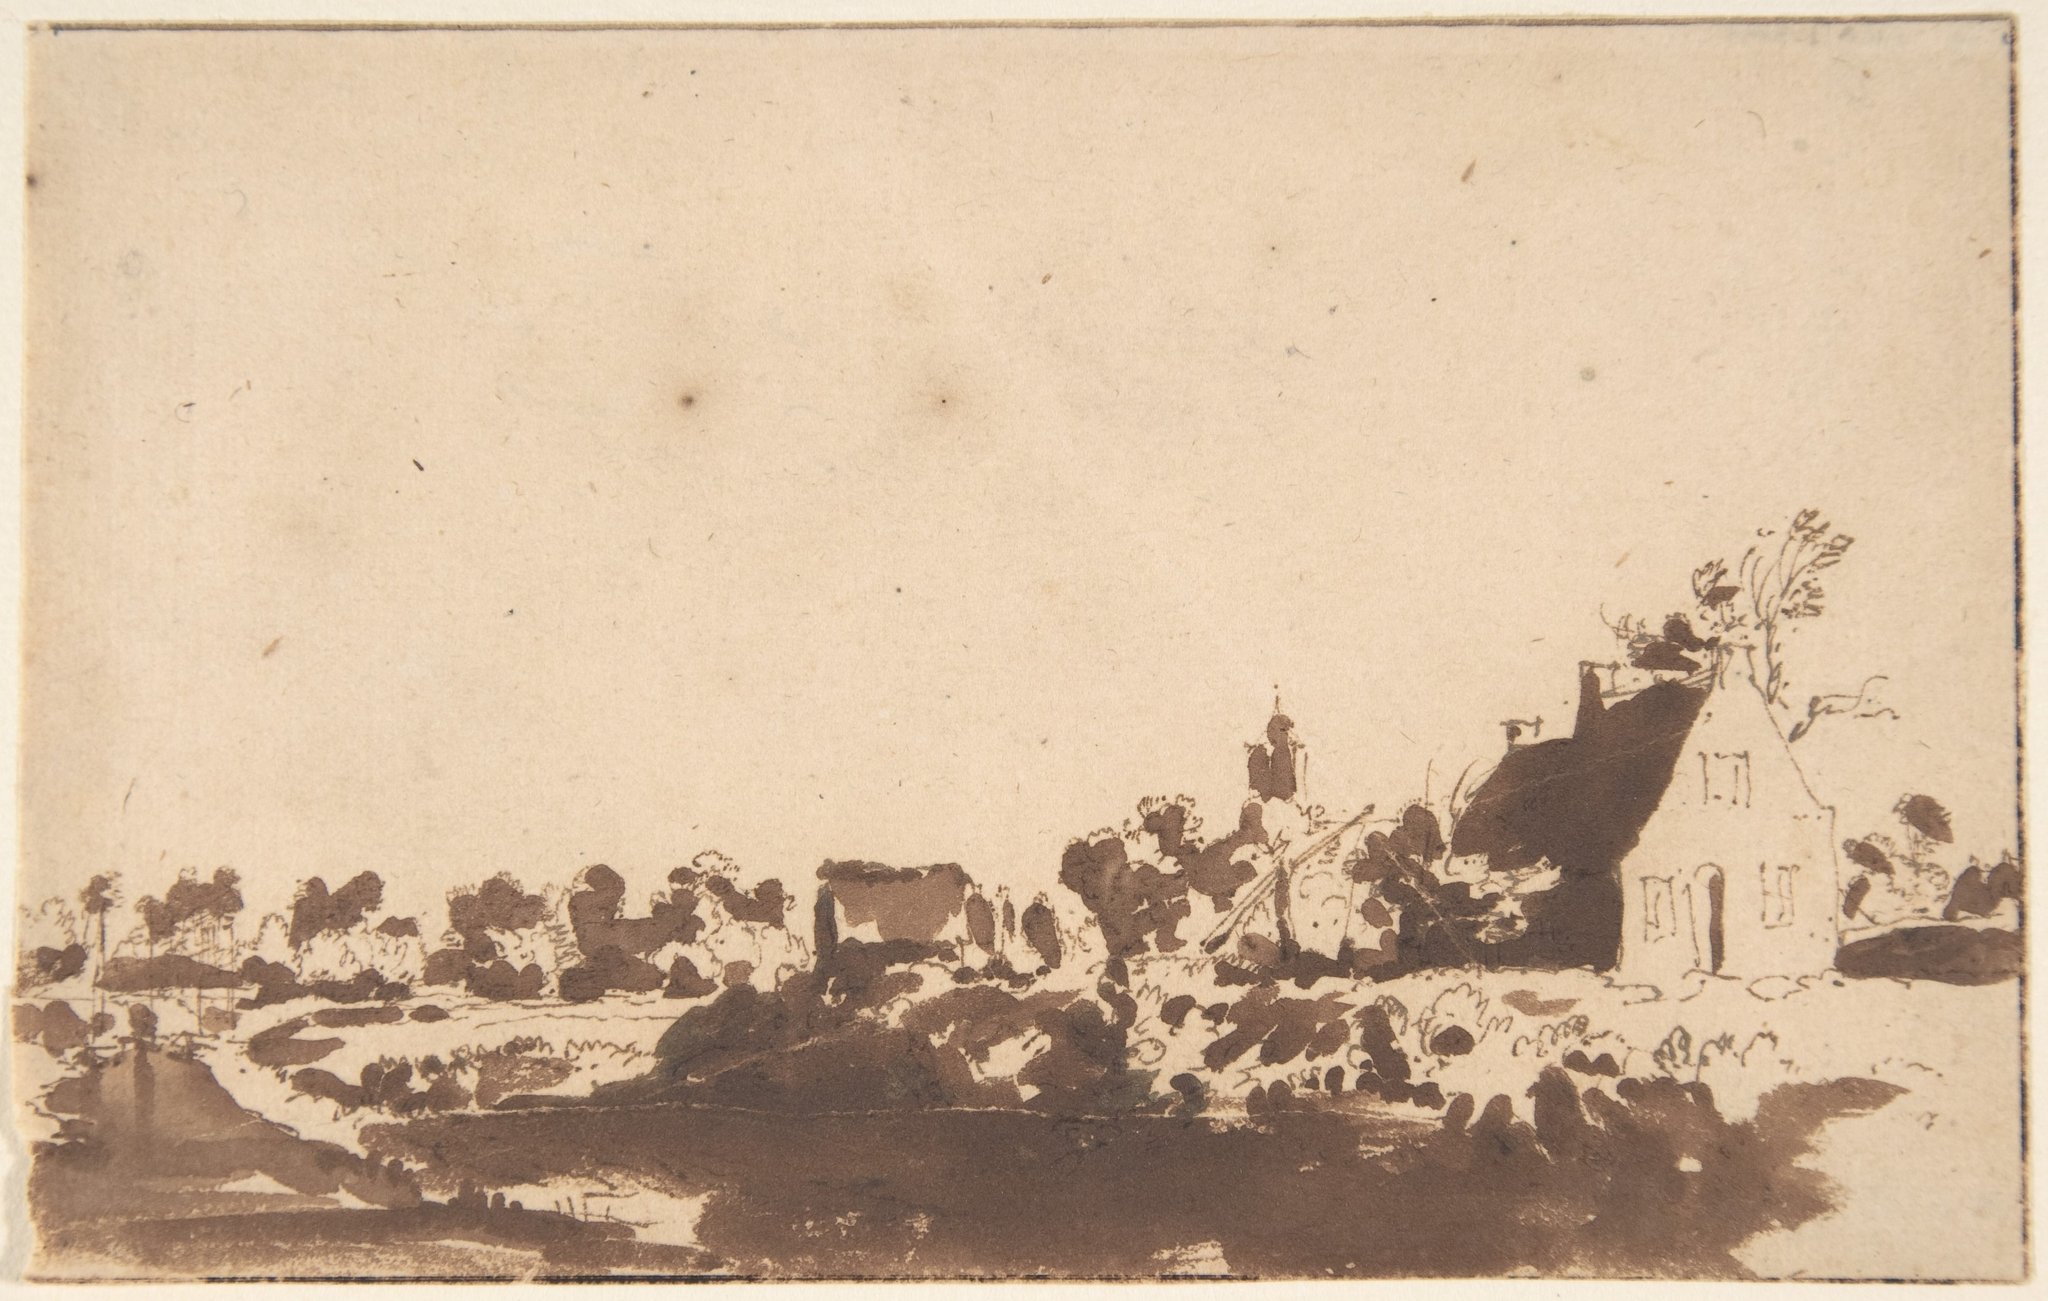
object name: drawing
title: View of a Village ("Wasschout"?)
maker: jan de bisschop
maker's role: artist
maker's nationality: dutch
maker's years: 1628-1671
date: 1634-1666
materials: ink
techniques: brush, pen, wash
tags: houses,villages,trees